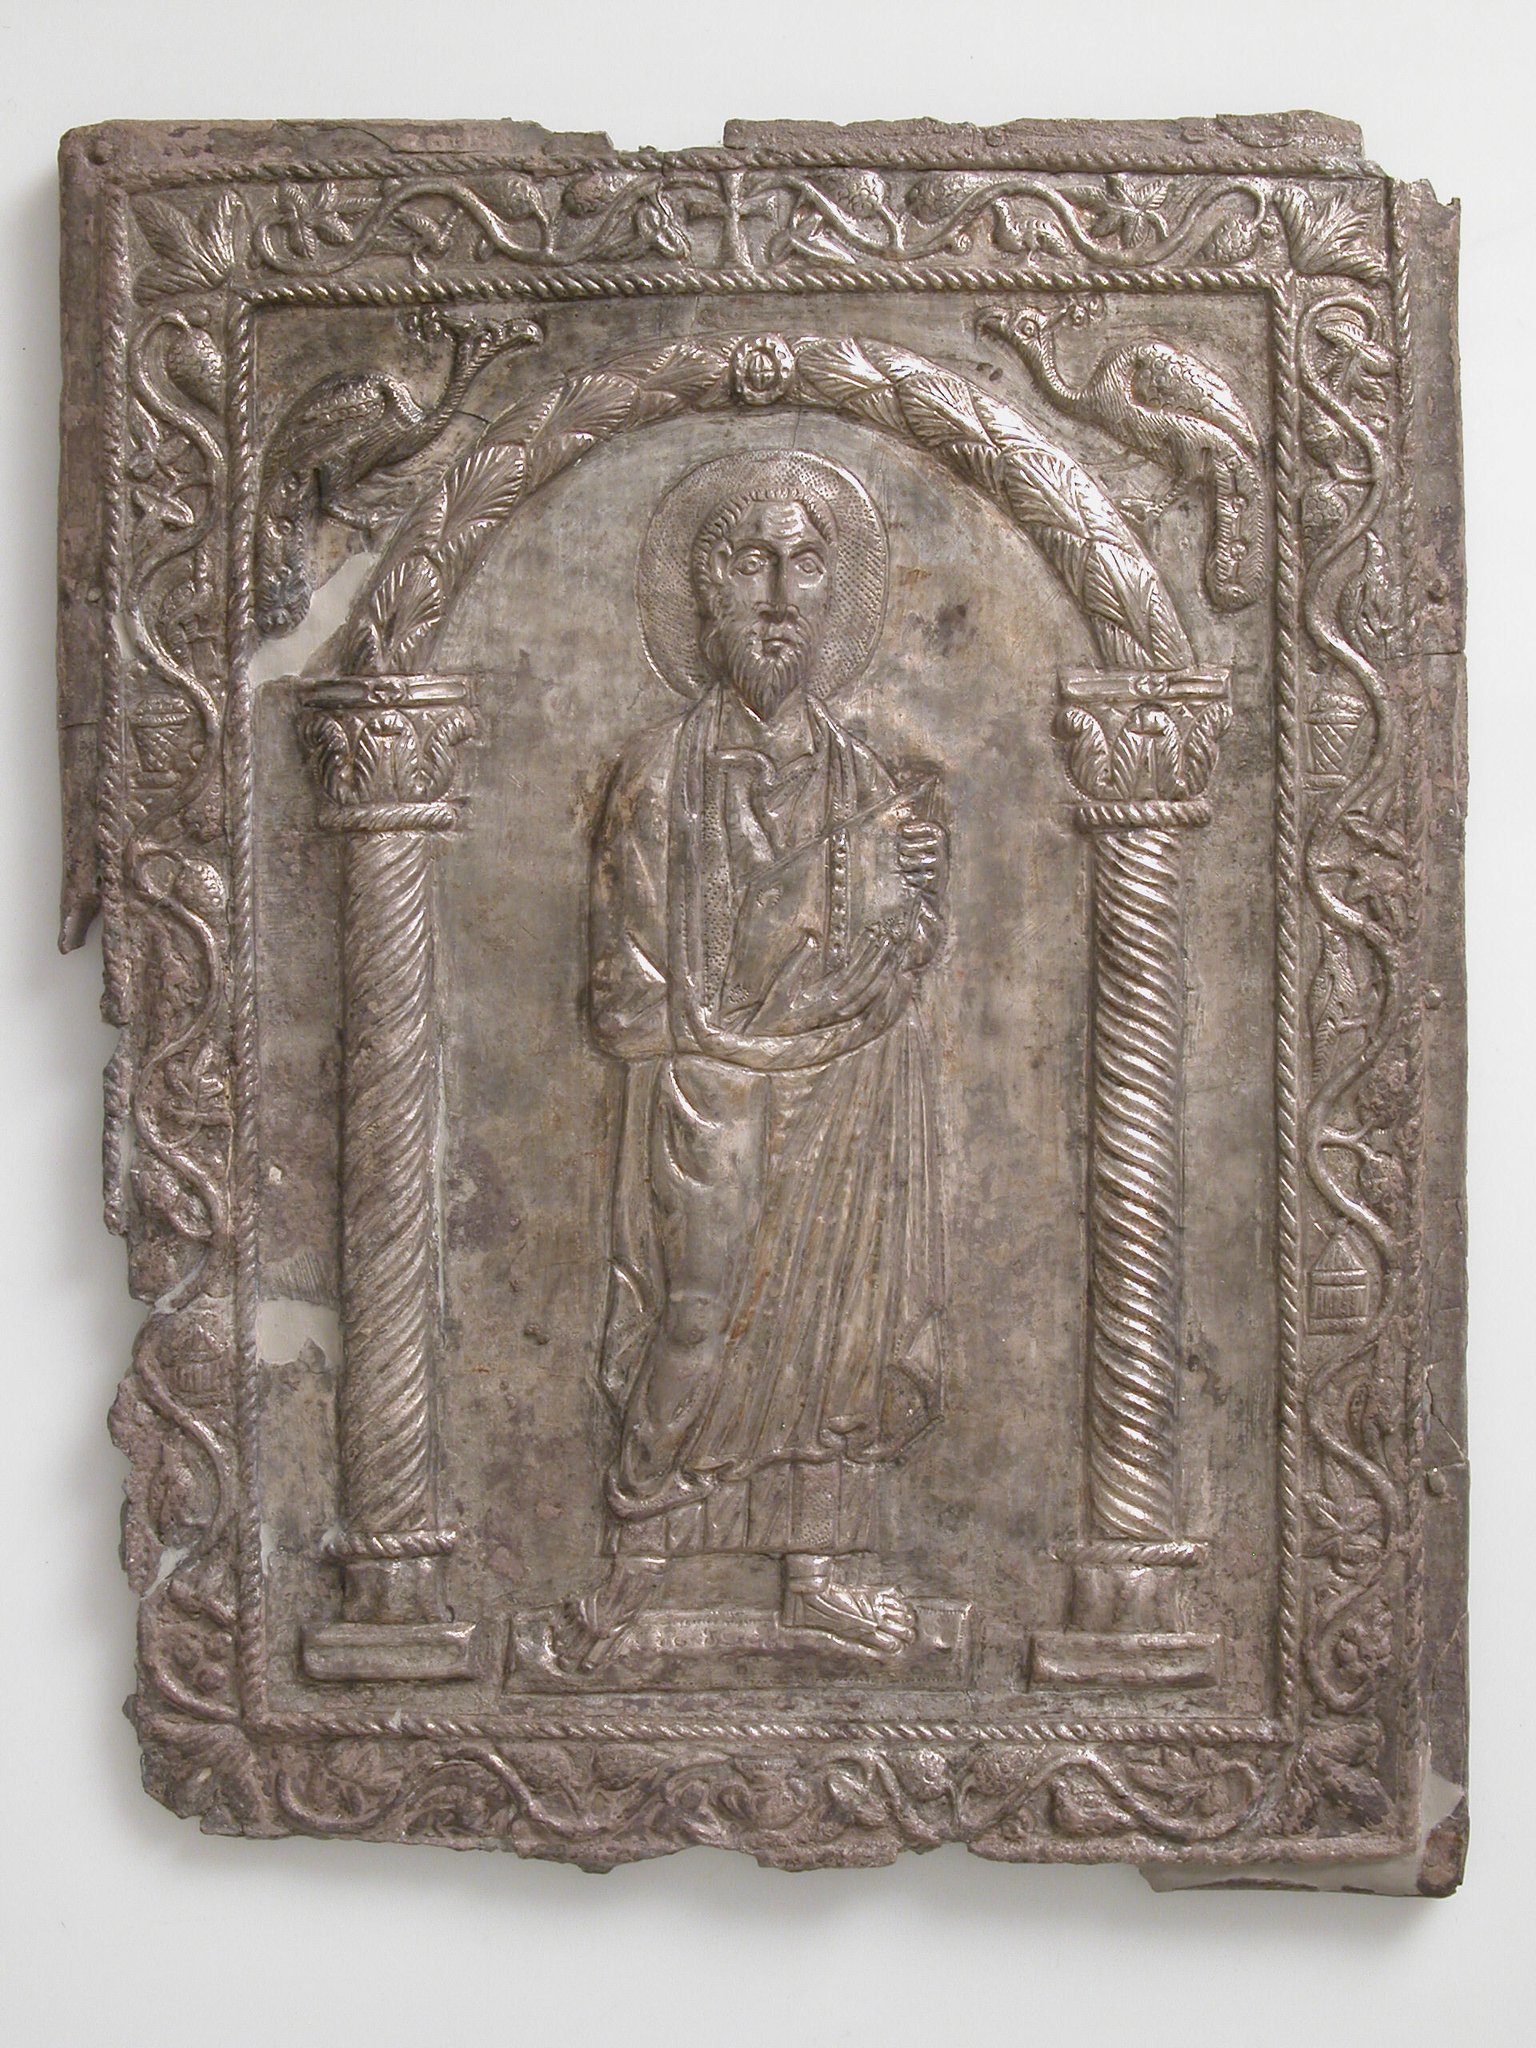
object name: book cover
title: Plaque with Saint Paul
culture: byzantine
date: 550-600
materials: gilt, silver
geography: antioch or kaper koraon (?)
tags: birds